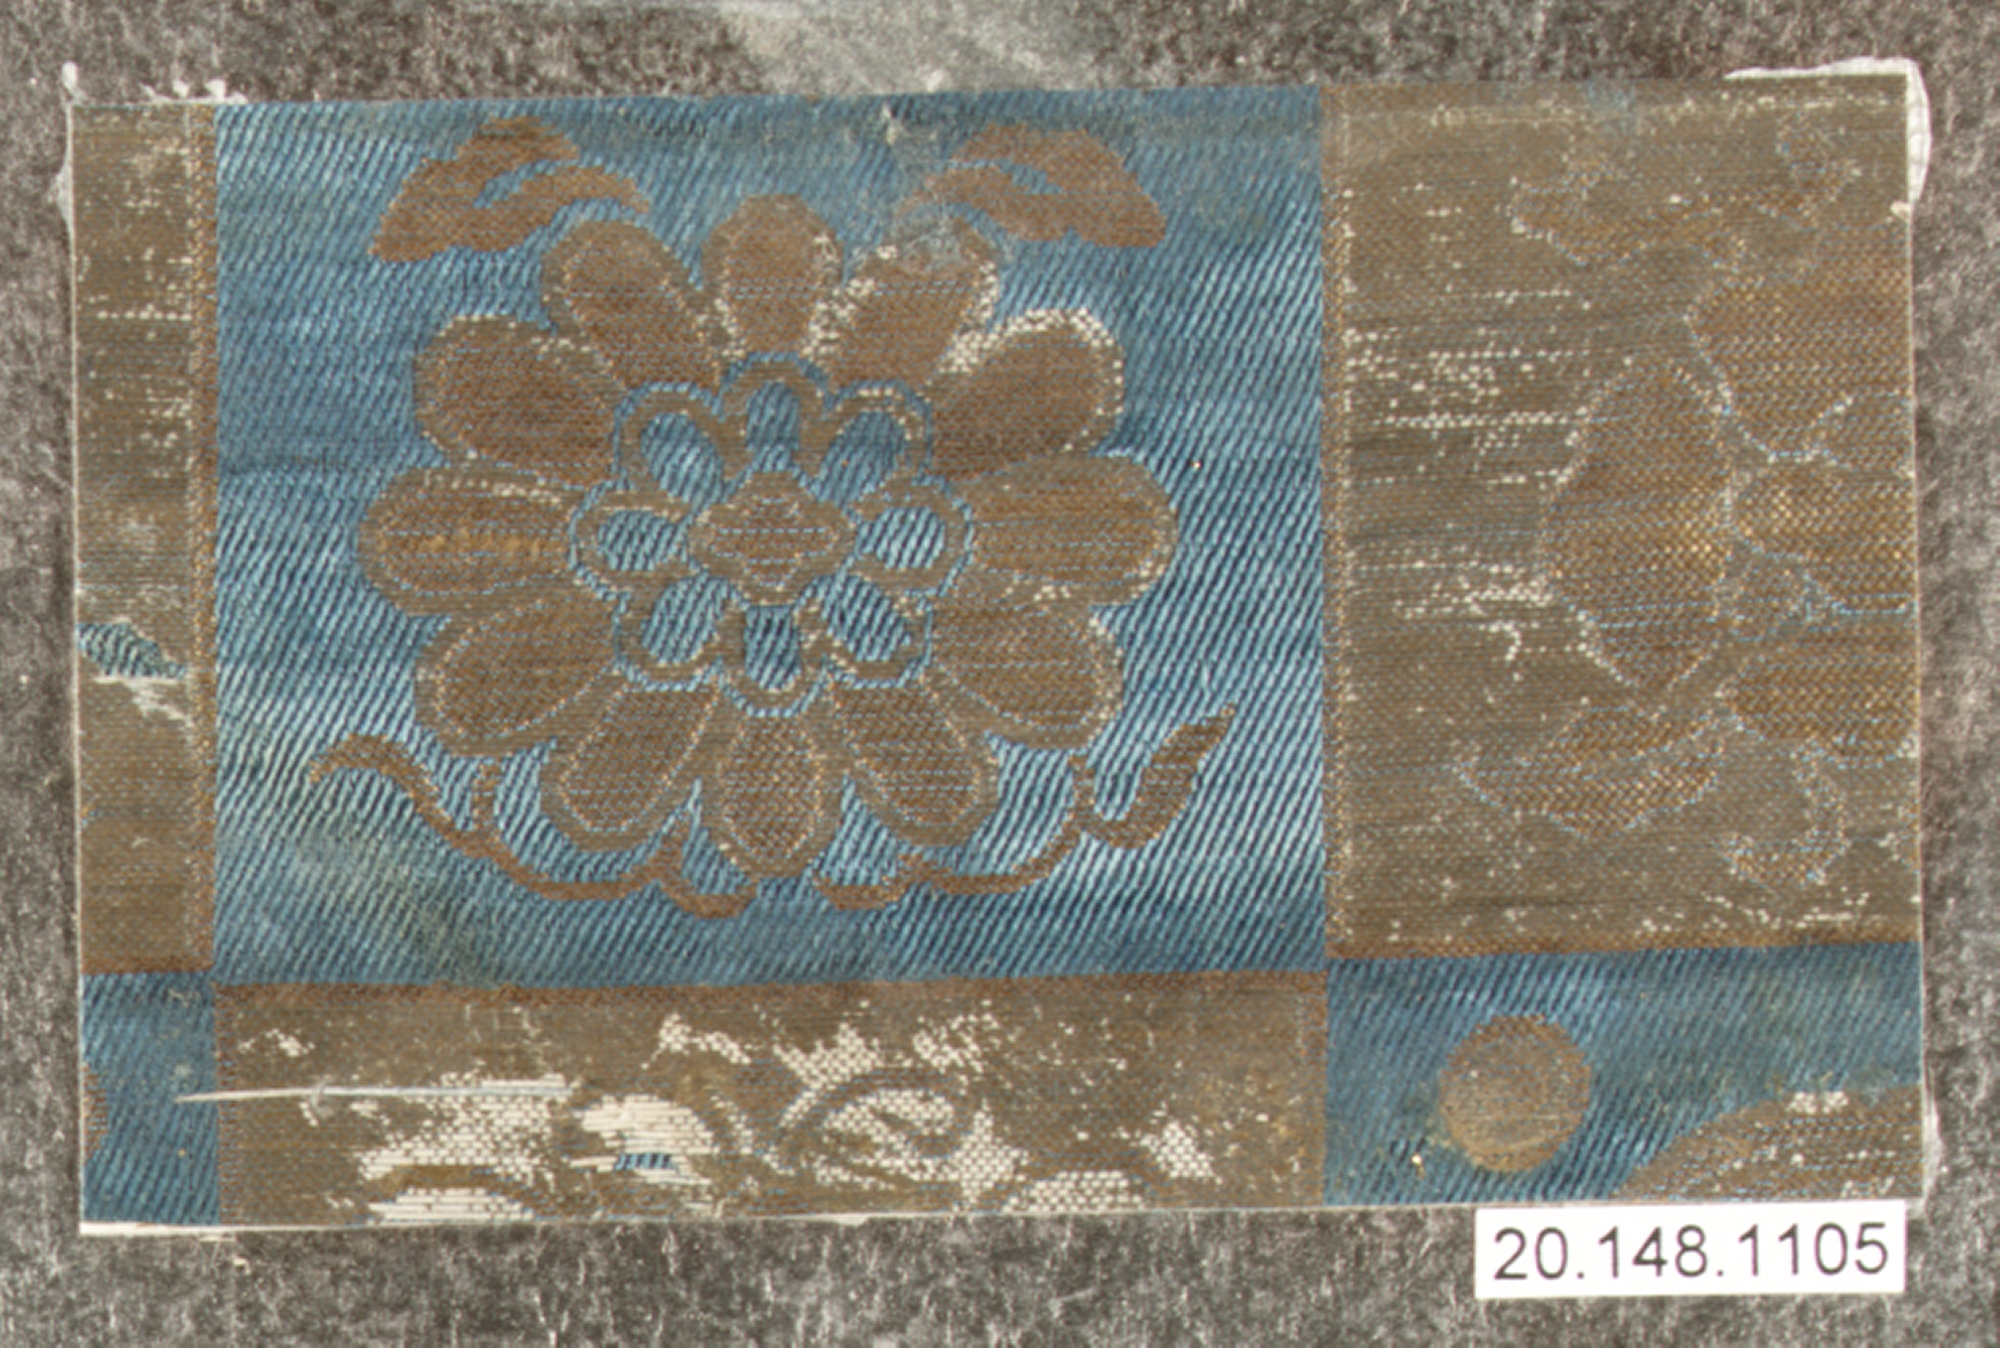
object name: piece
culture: japanese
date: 1701-1800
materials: silk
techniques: compound weave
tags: flowers